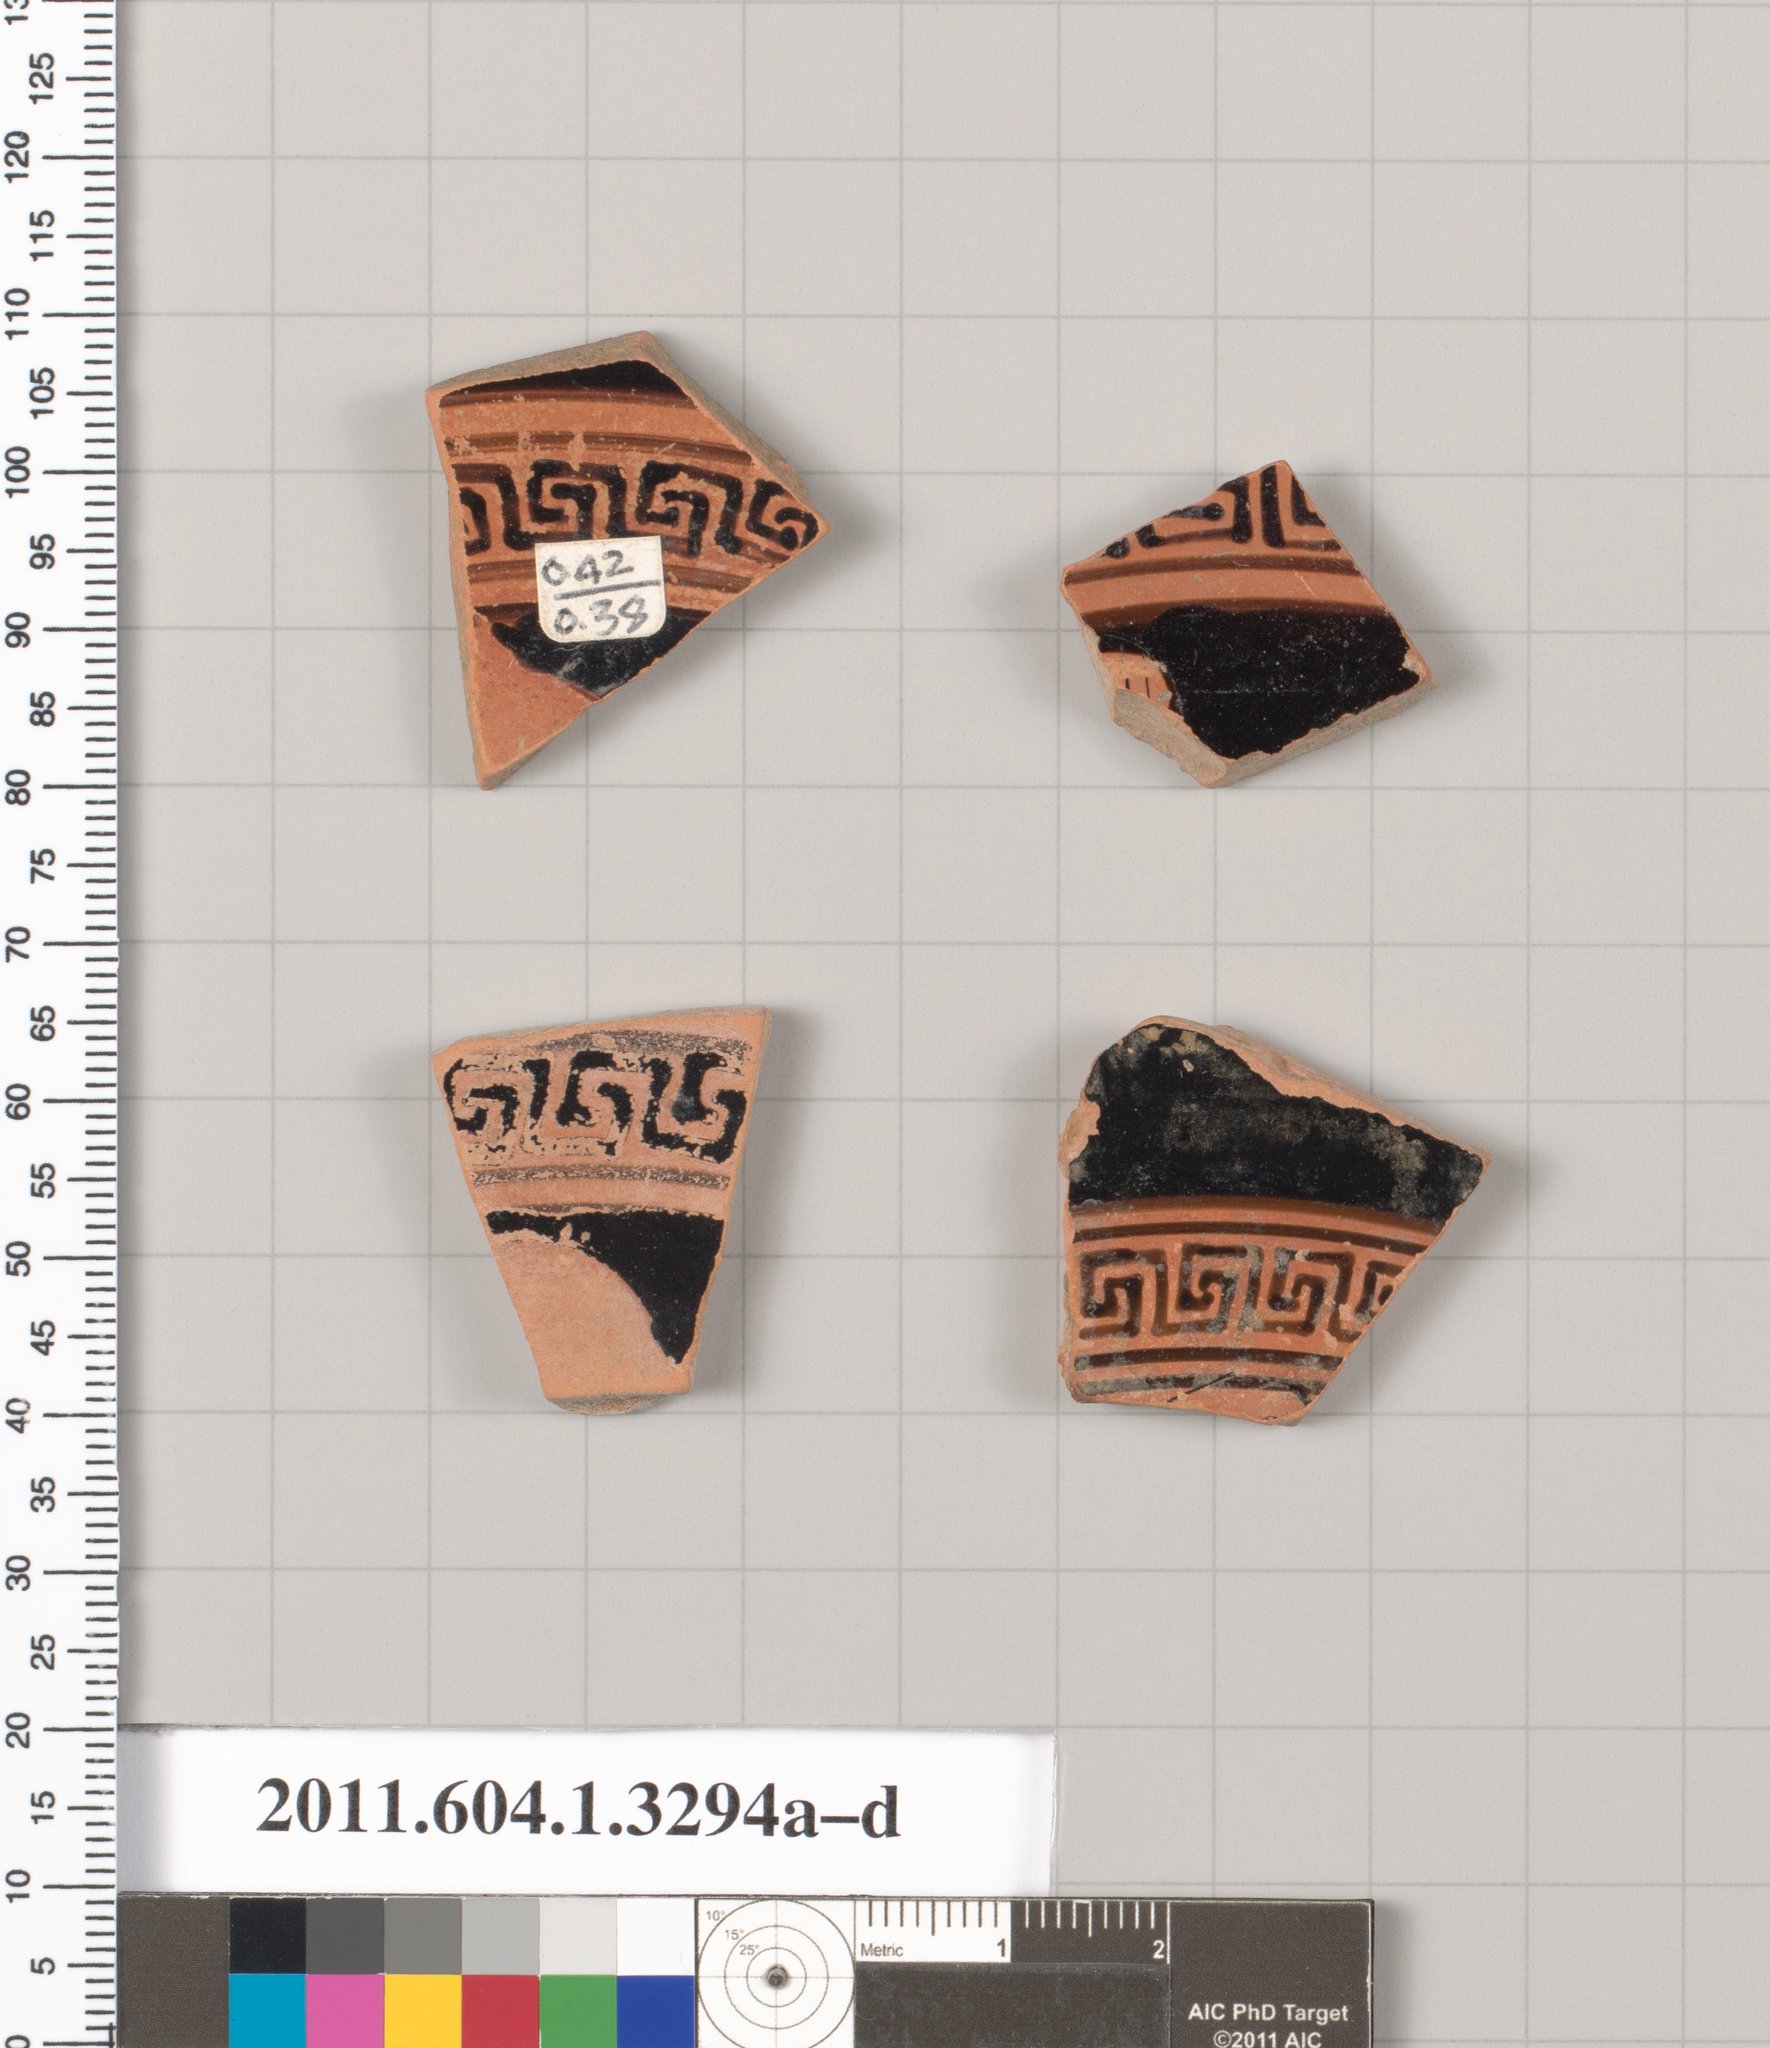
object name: kylix fragment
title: Terracotta fragments of kylikes (drinking cups)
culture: greek, attic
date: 500-480 BCE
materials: terracotta